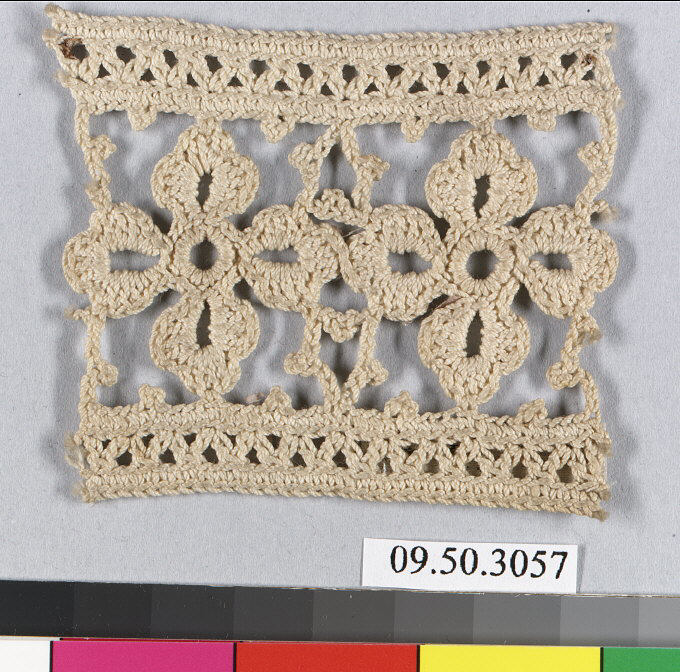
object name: sample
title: Crochet Work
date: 1801-1900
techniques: crochet